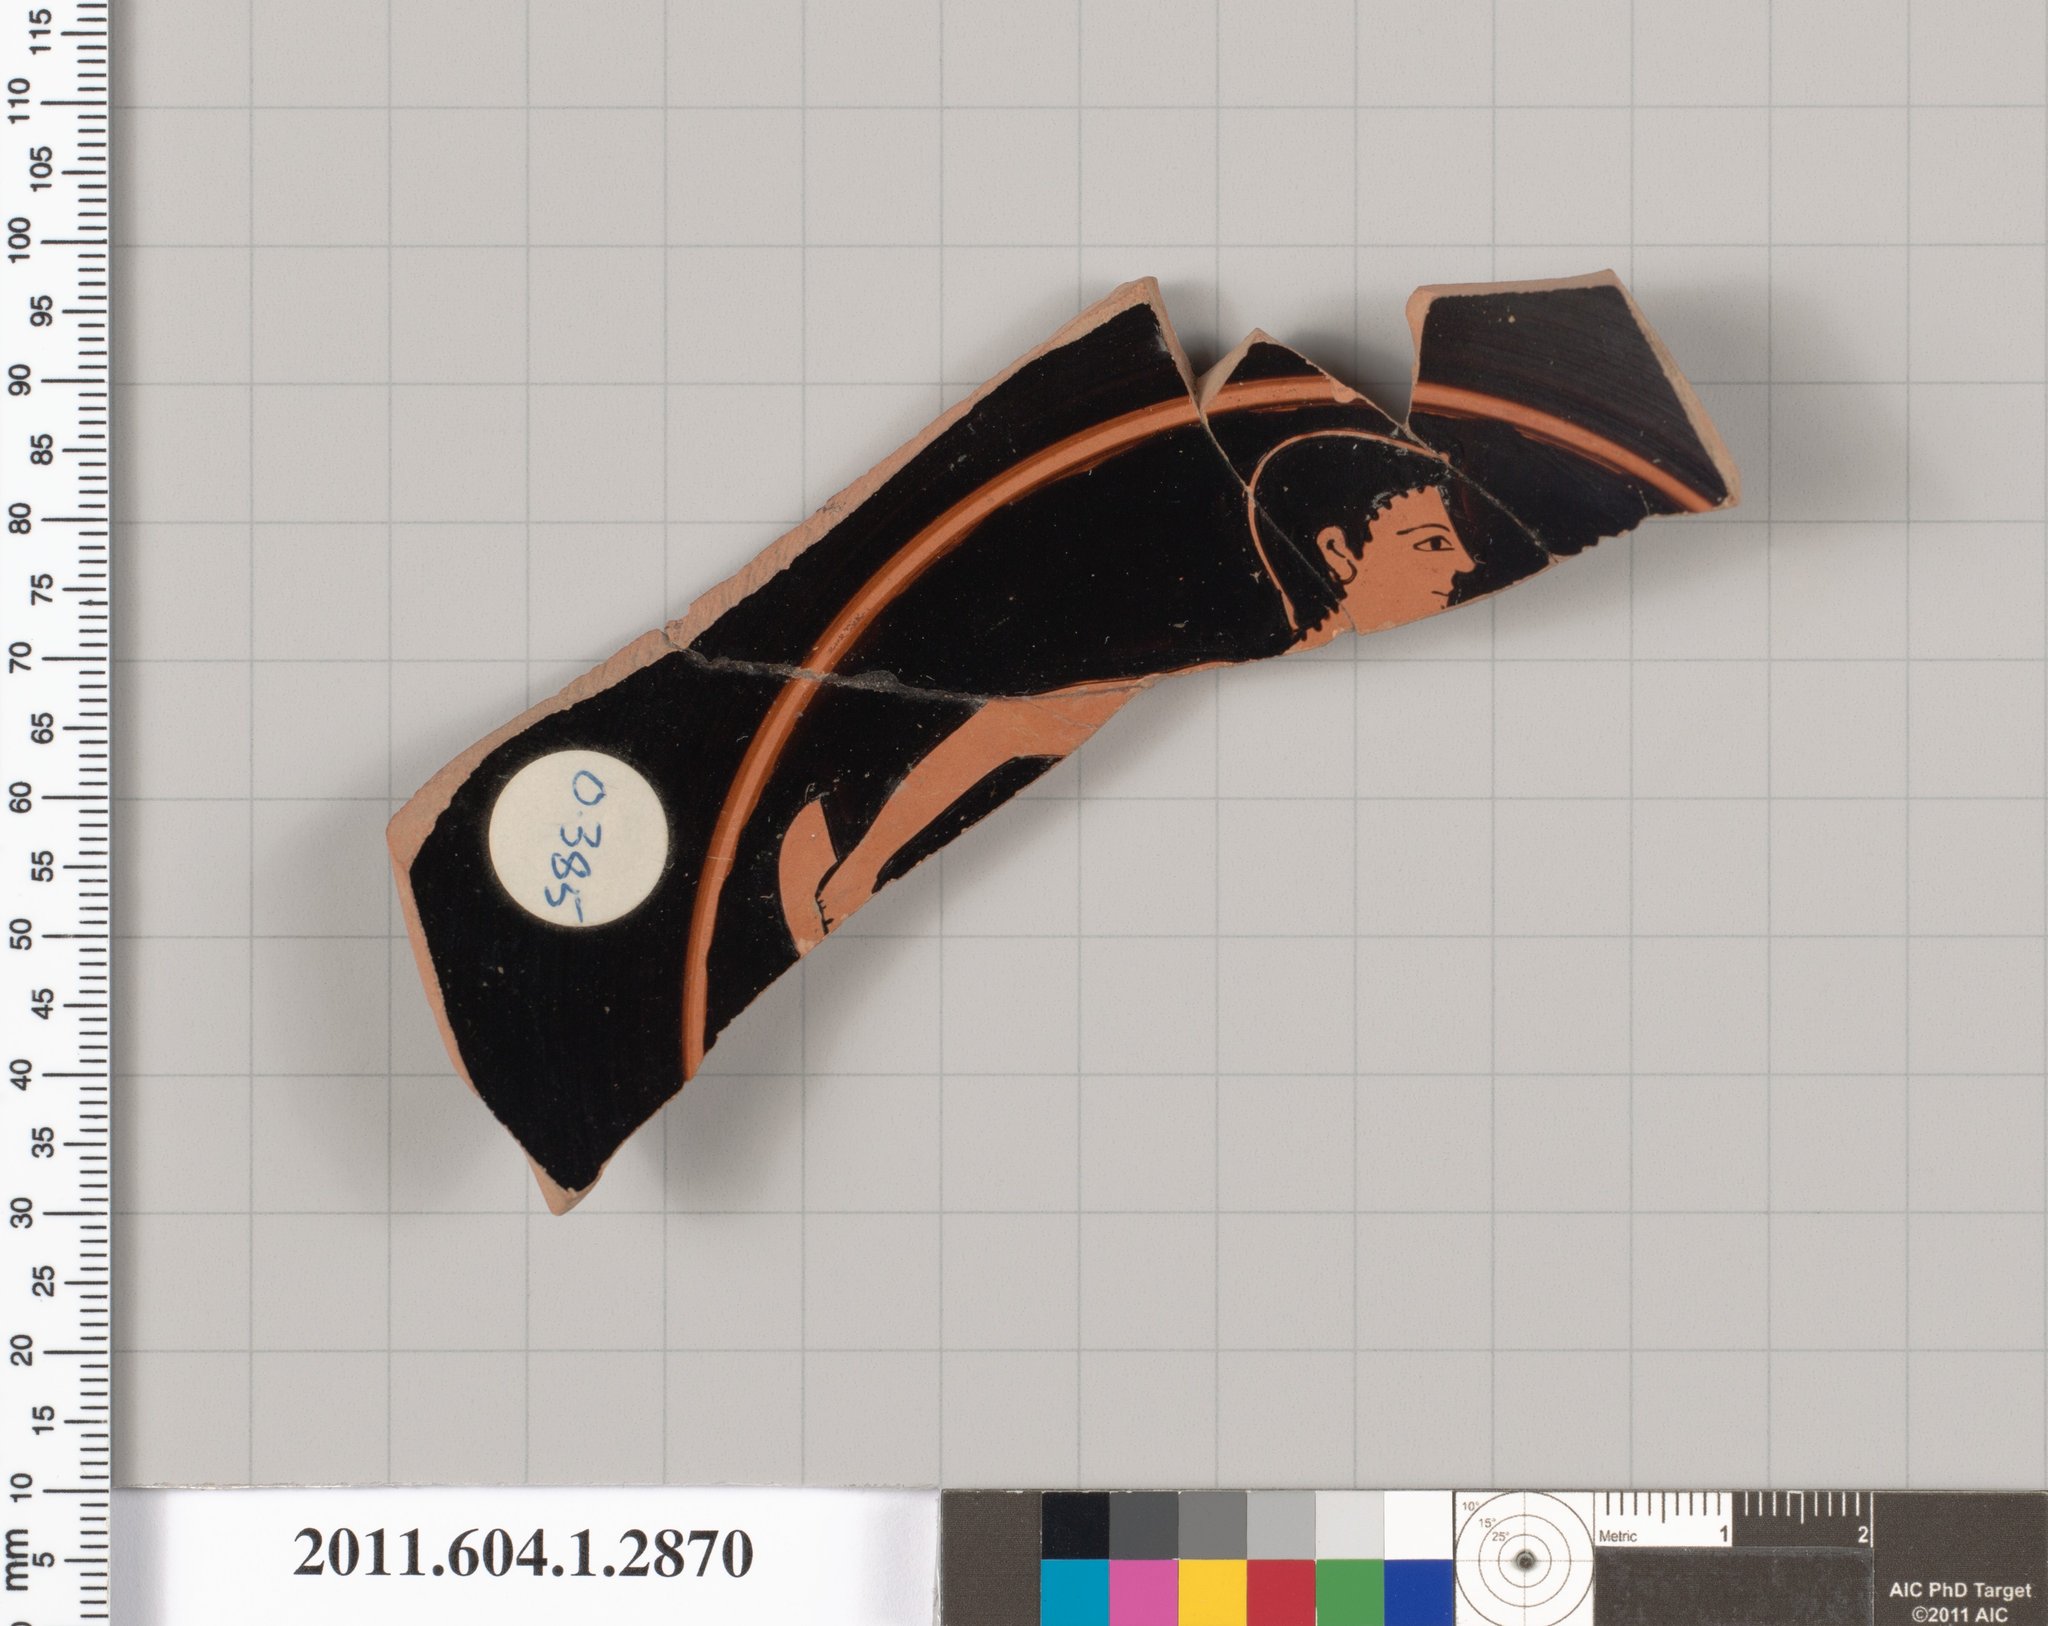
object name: kylix fragment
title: Terracotta fragment of a kylix (drinking cup)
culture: greek, attic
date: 520-500 BCE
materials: terracotta